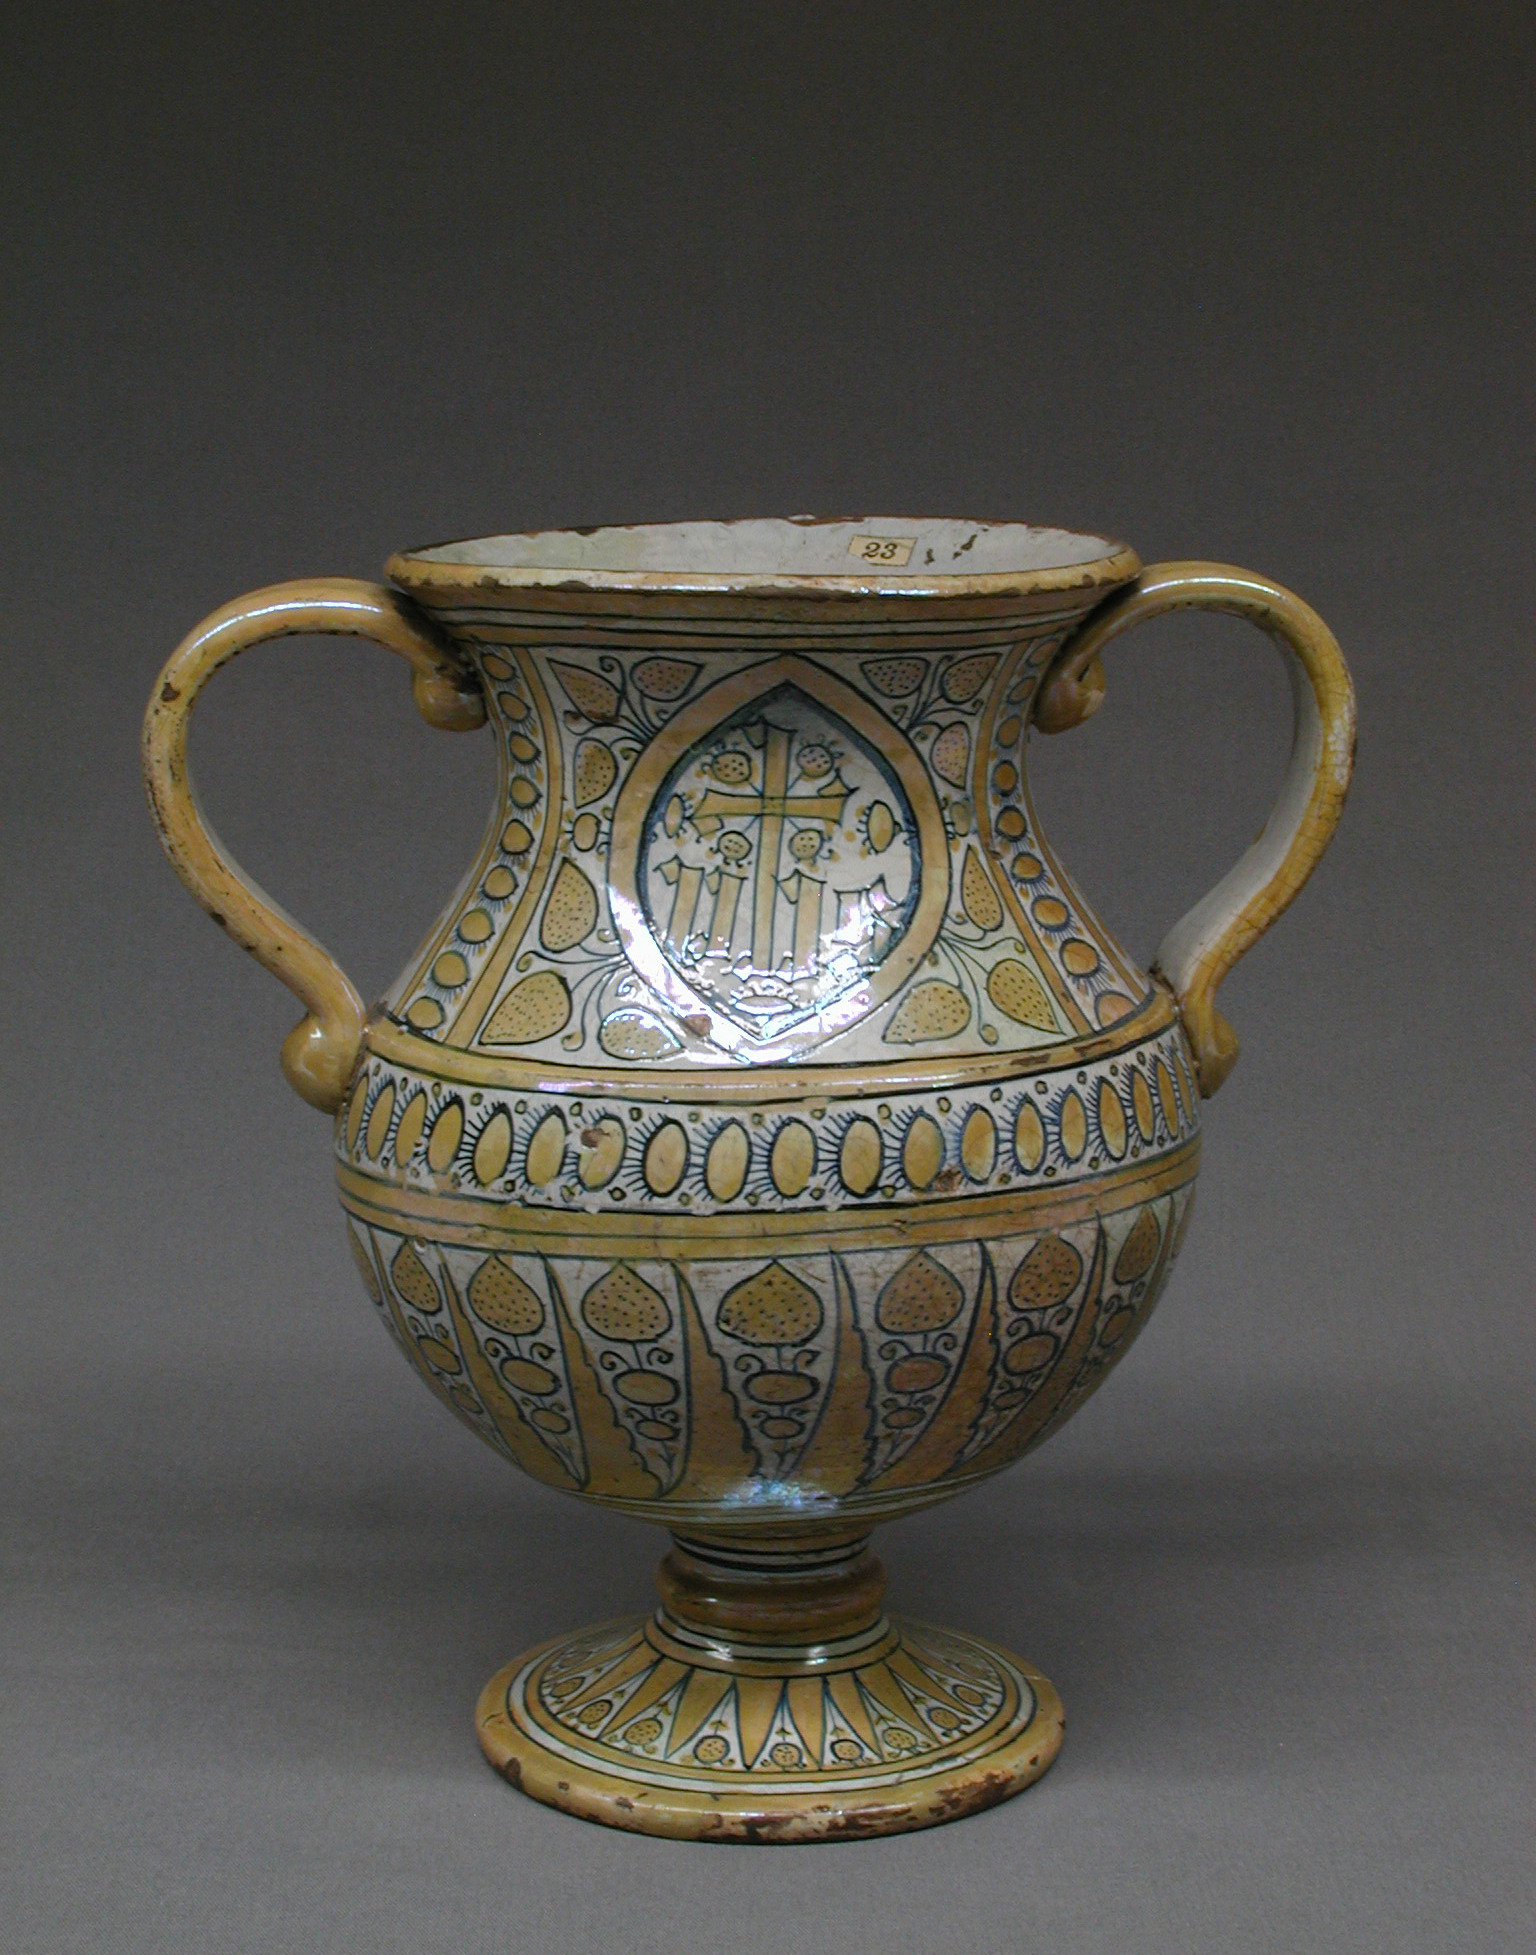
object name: vase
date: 1520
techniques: maiolica, glazing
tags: cross